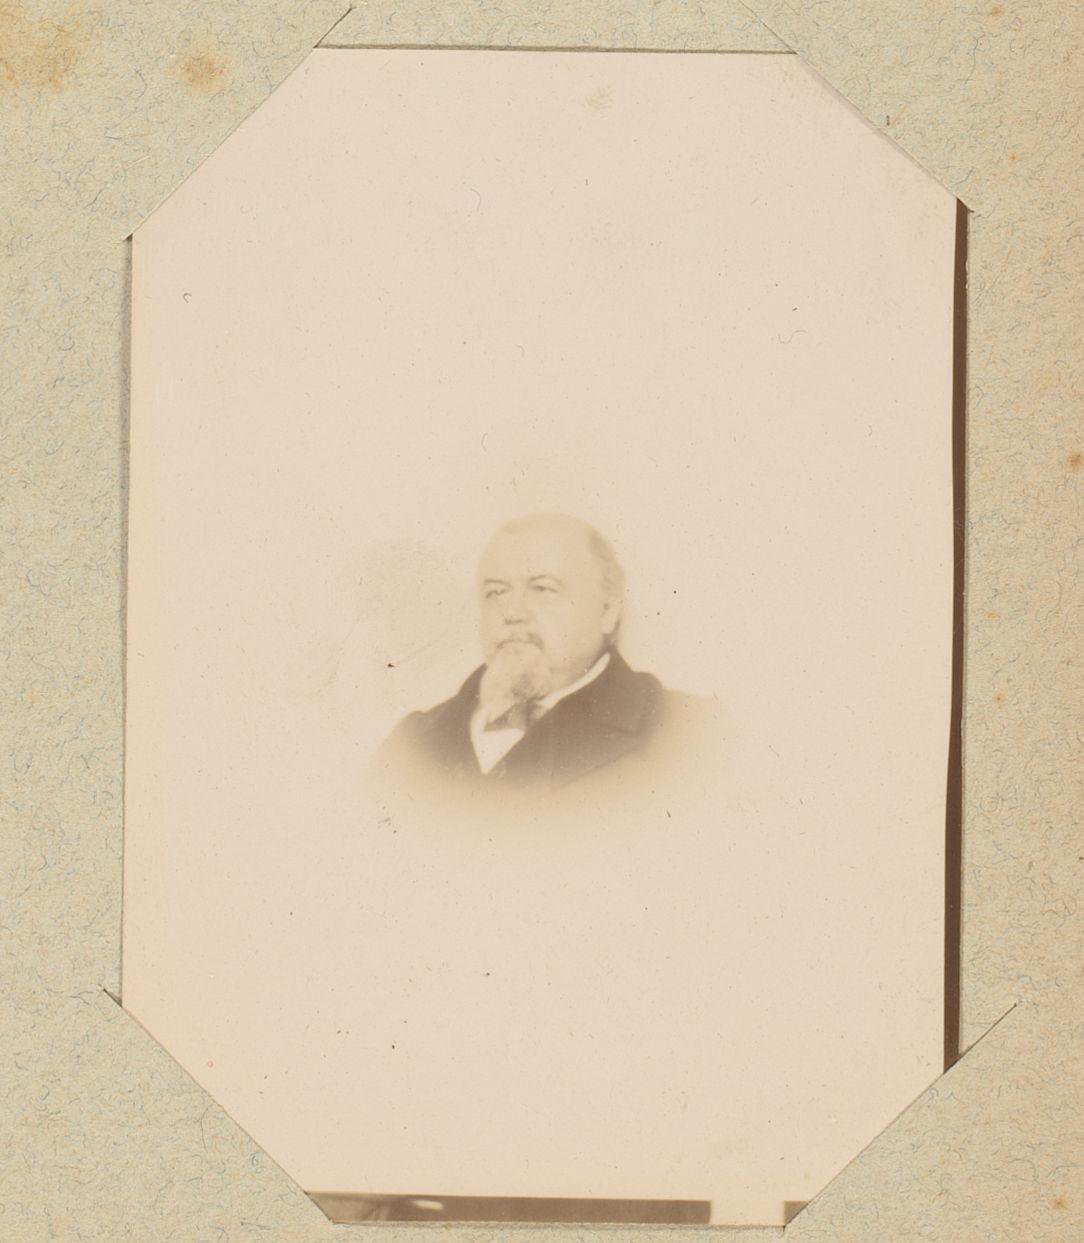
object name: album leaf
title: Portret van een man met baard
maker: Anonymous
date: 1897-1900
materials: paper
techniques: gelatin silver print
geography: france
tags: adult man, historical persons, beard, france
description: Over de foto is een ander negatief afgedrukt van een voorstelling van bomen.